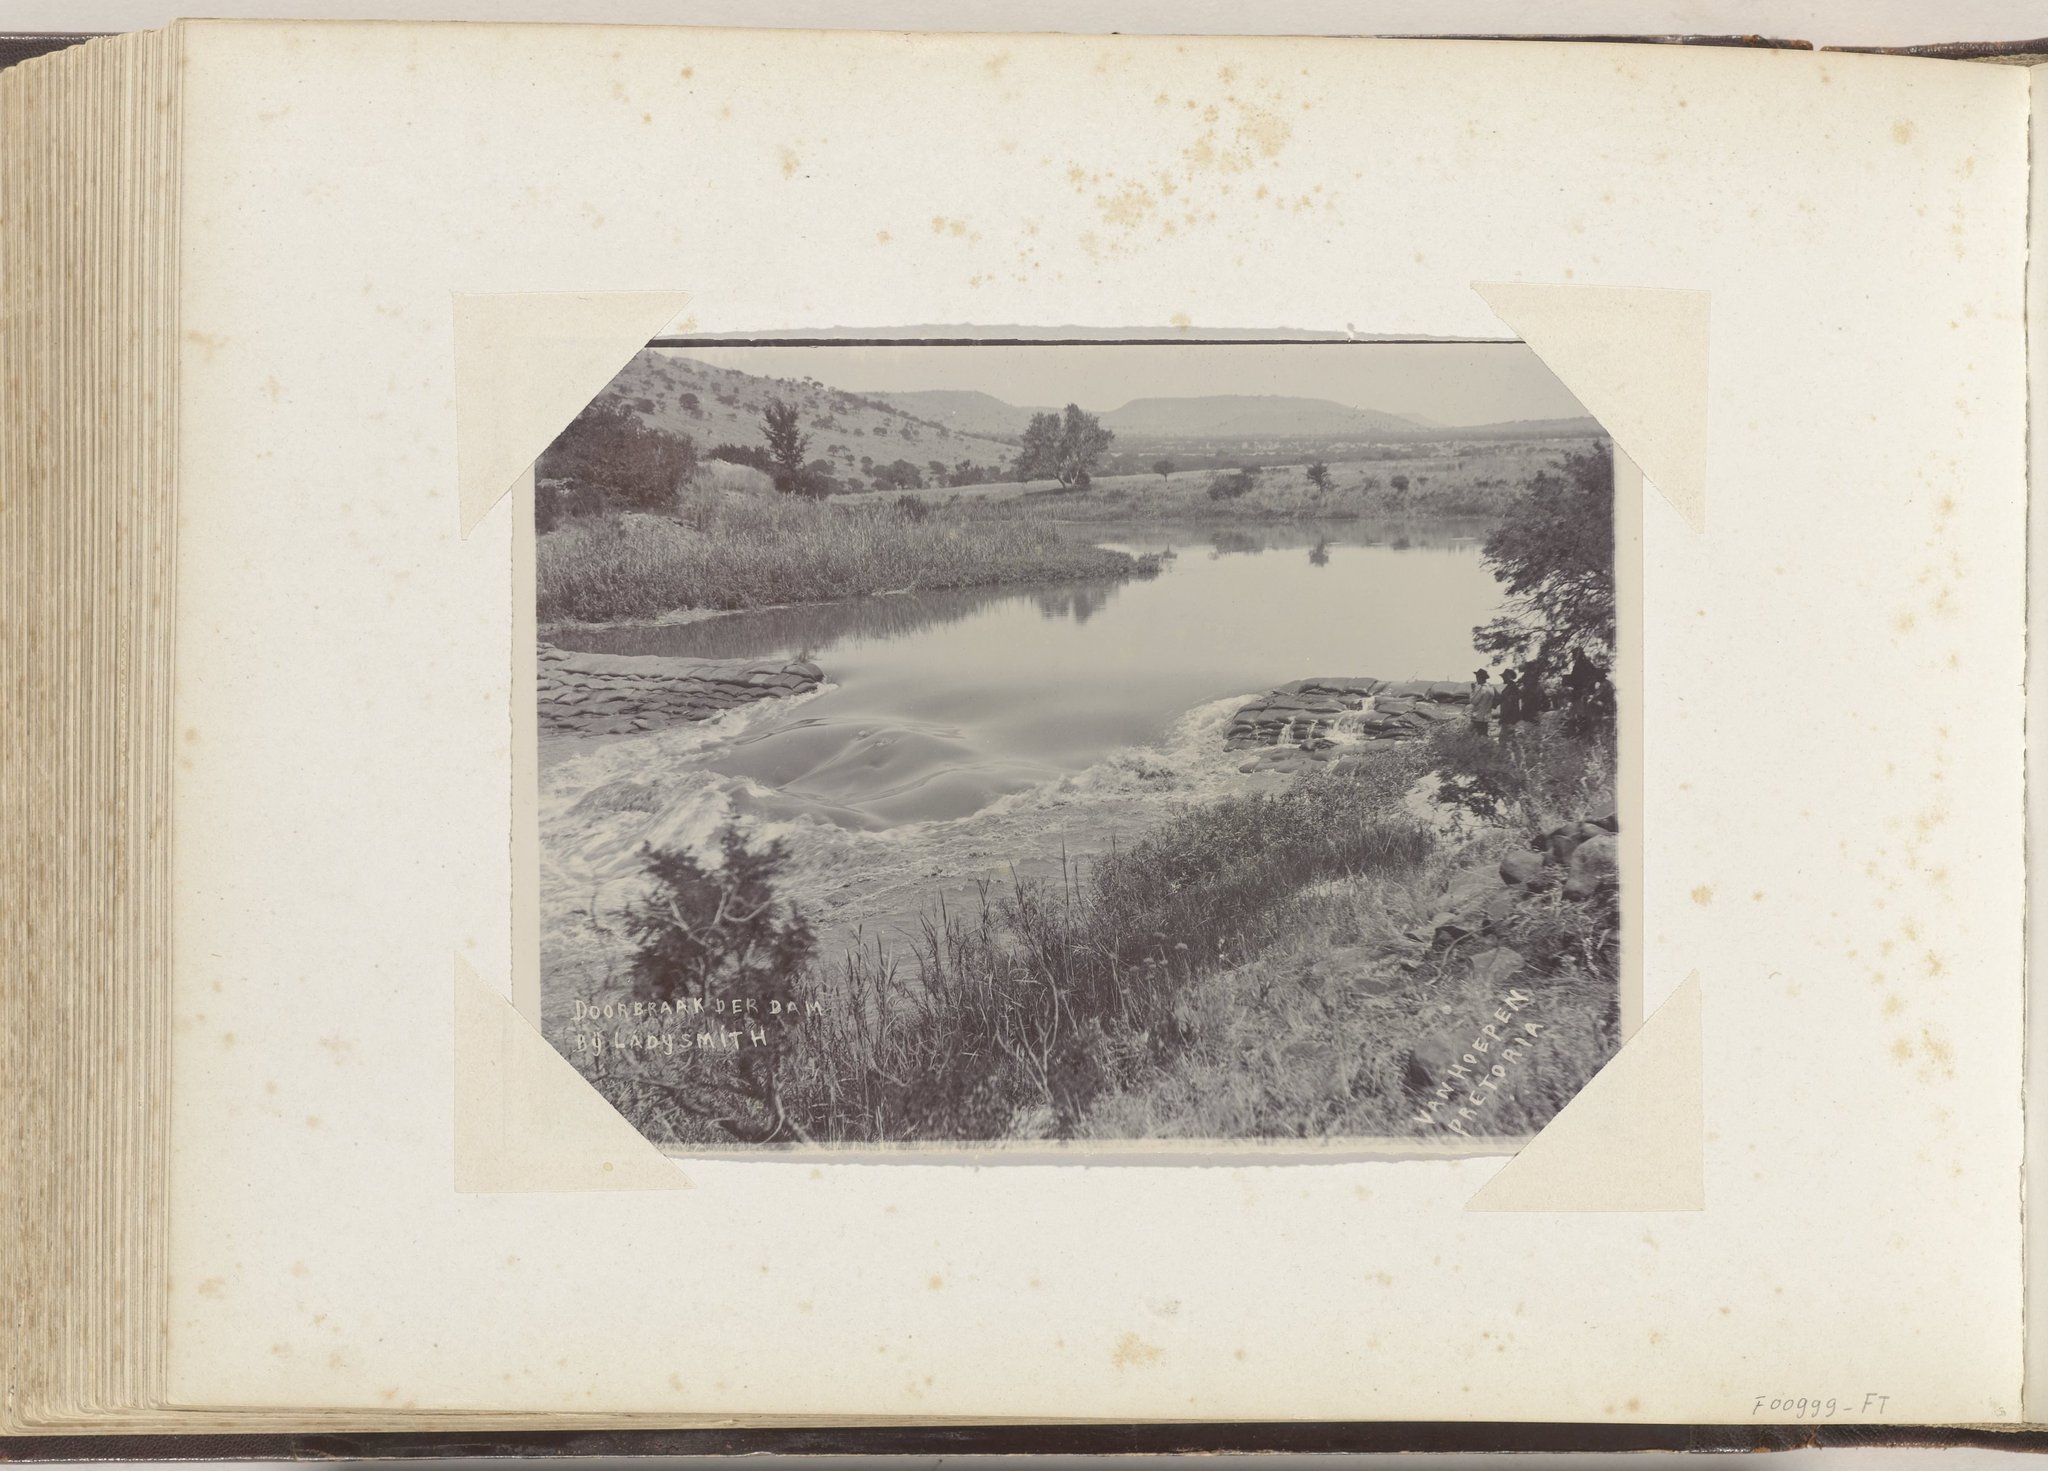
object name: photograph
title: Doorgebroken dam bij Ladysmith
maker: jan van hoepen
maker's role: fotograaf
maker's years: 1856-1922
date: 1899-1900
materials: paper, photographic support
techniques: gelatin silver print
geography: ladysmith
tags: dammed-up lake, dam (in canal)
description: Onderdeel van Album met 191 foto's van een reis naar en door Zuid-Afrika.